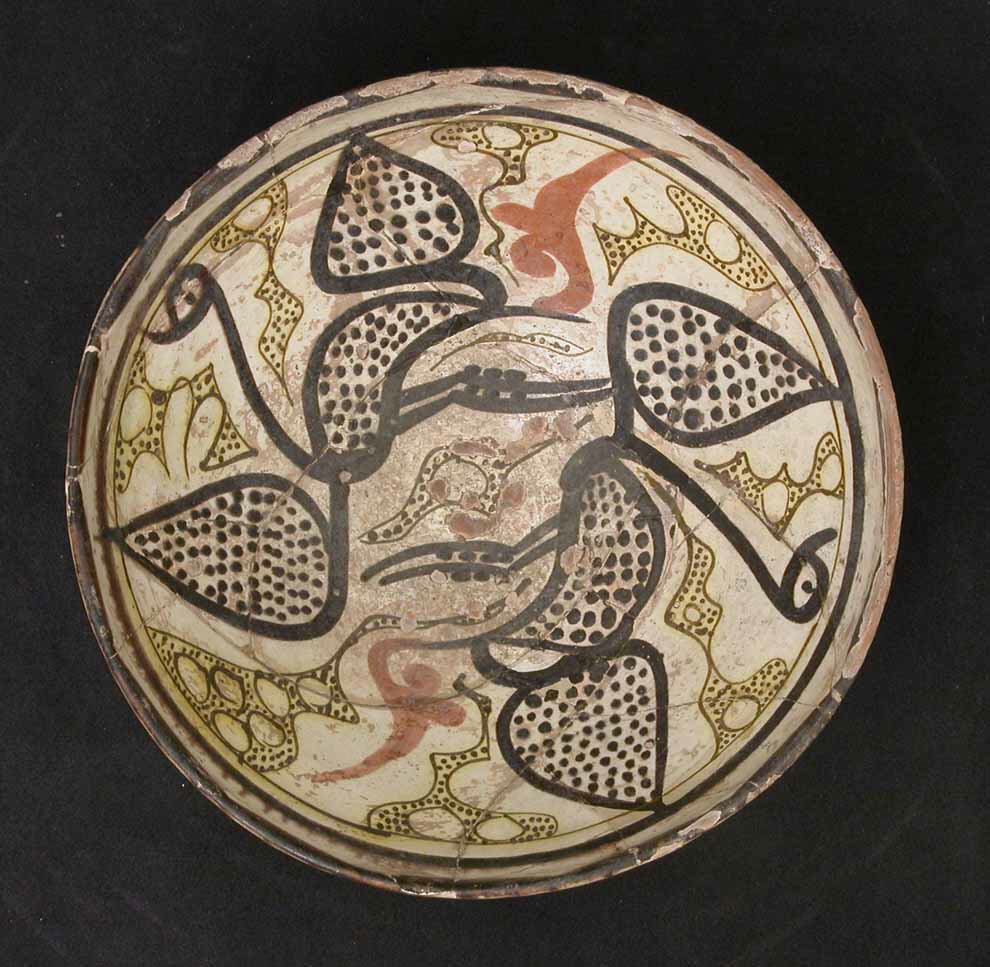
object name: bowl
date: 901-1000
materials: earthenware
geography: iran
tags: birds